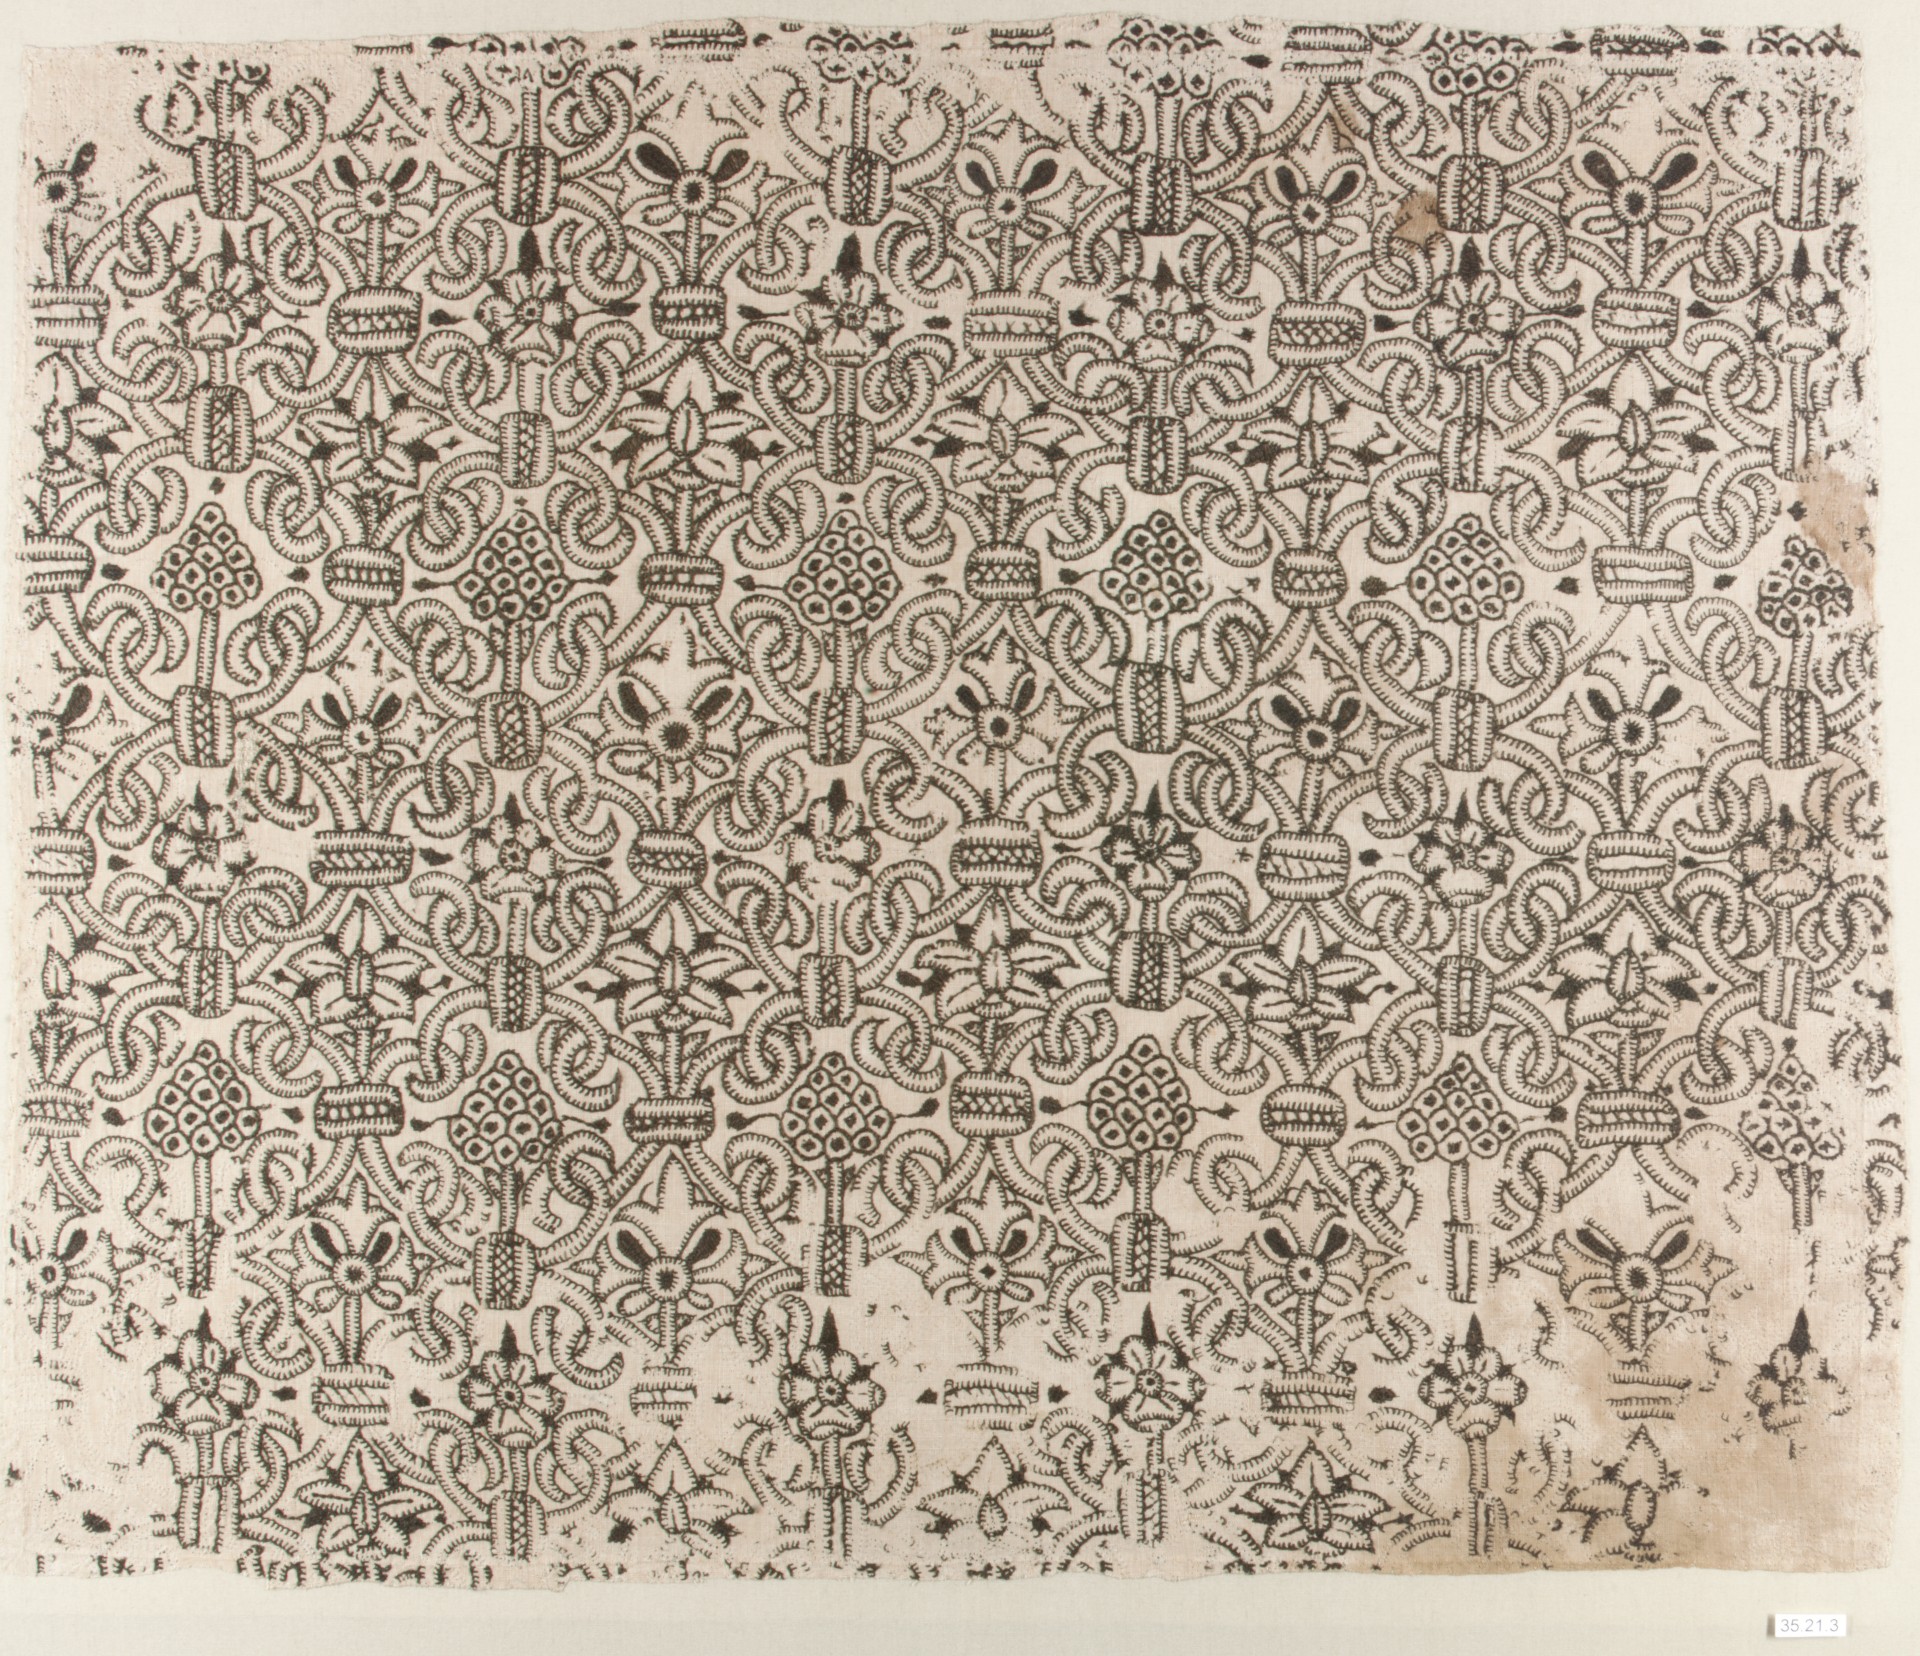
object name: piece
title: Panel of blackwork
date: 1580-1620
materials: linen, thread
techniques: stitching